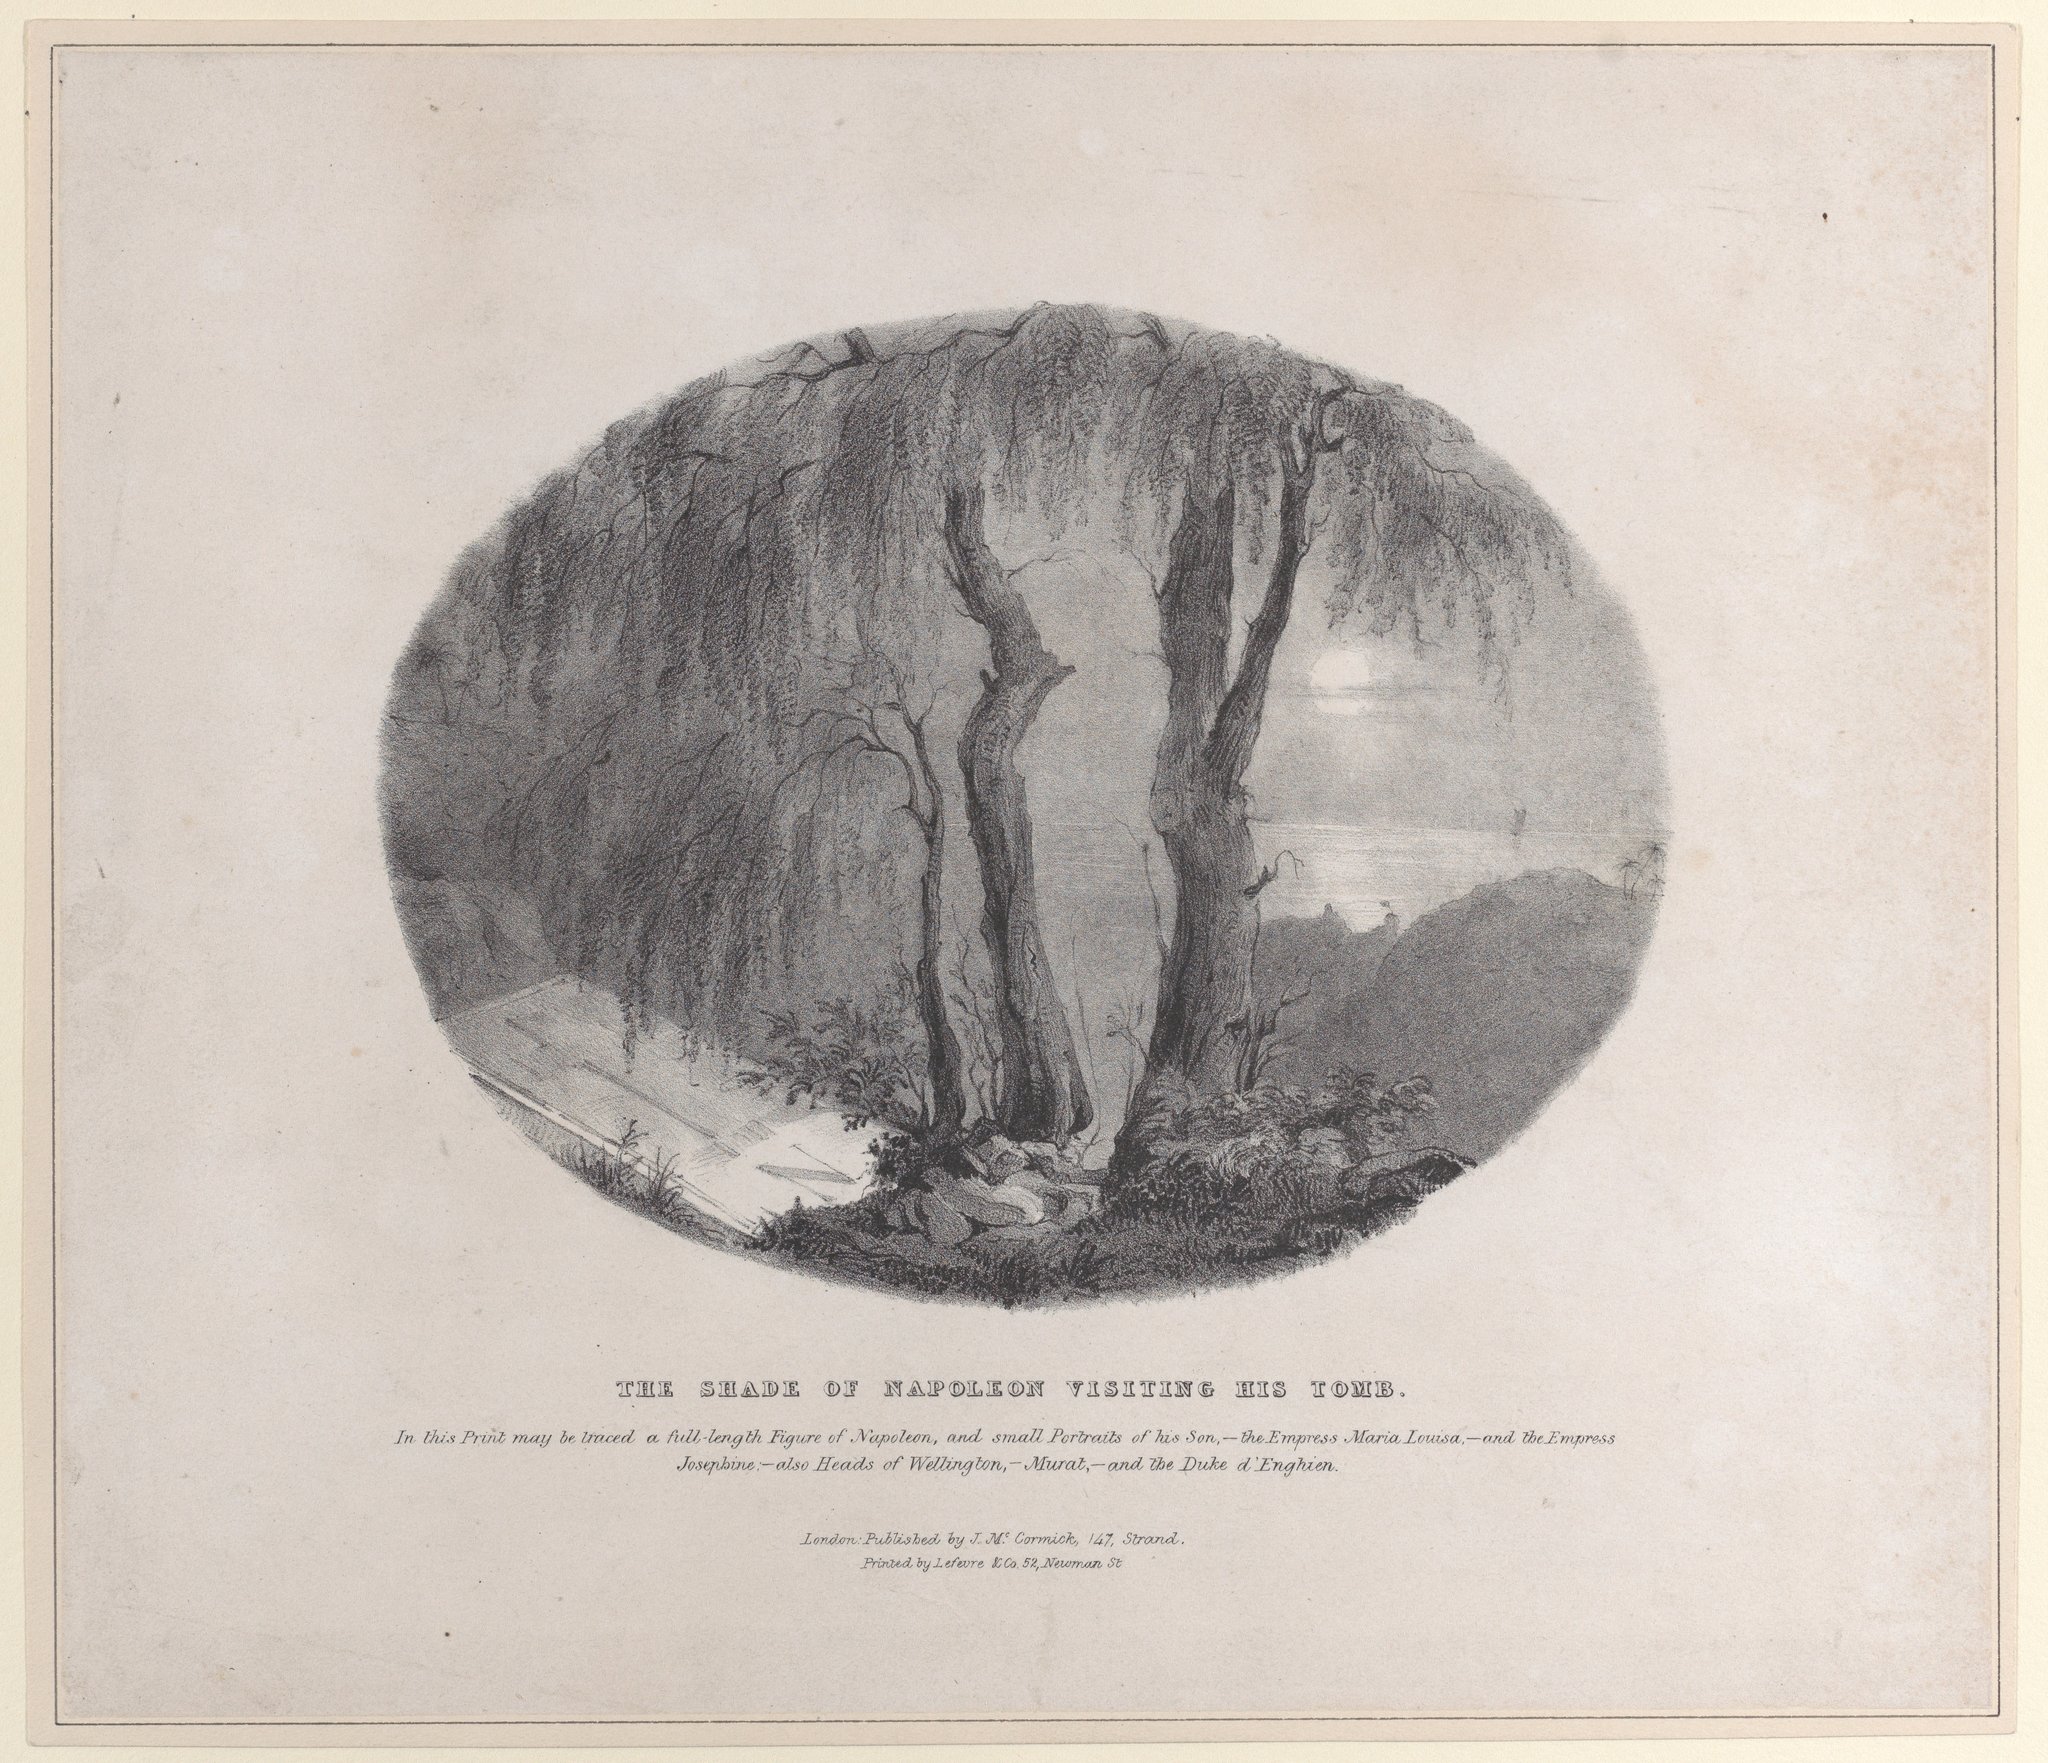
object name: print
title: The Tomb of Napoleon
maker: Anonymous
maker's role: artist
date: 1821-1900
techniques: lithograph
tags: tombs,napoleon i,trees